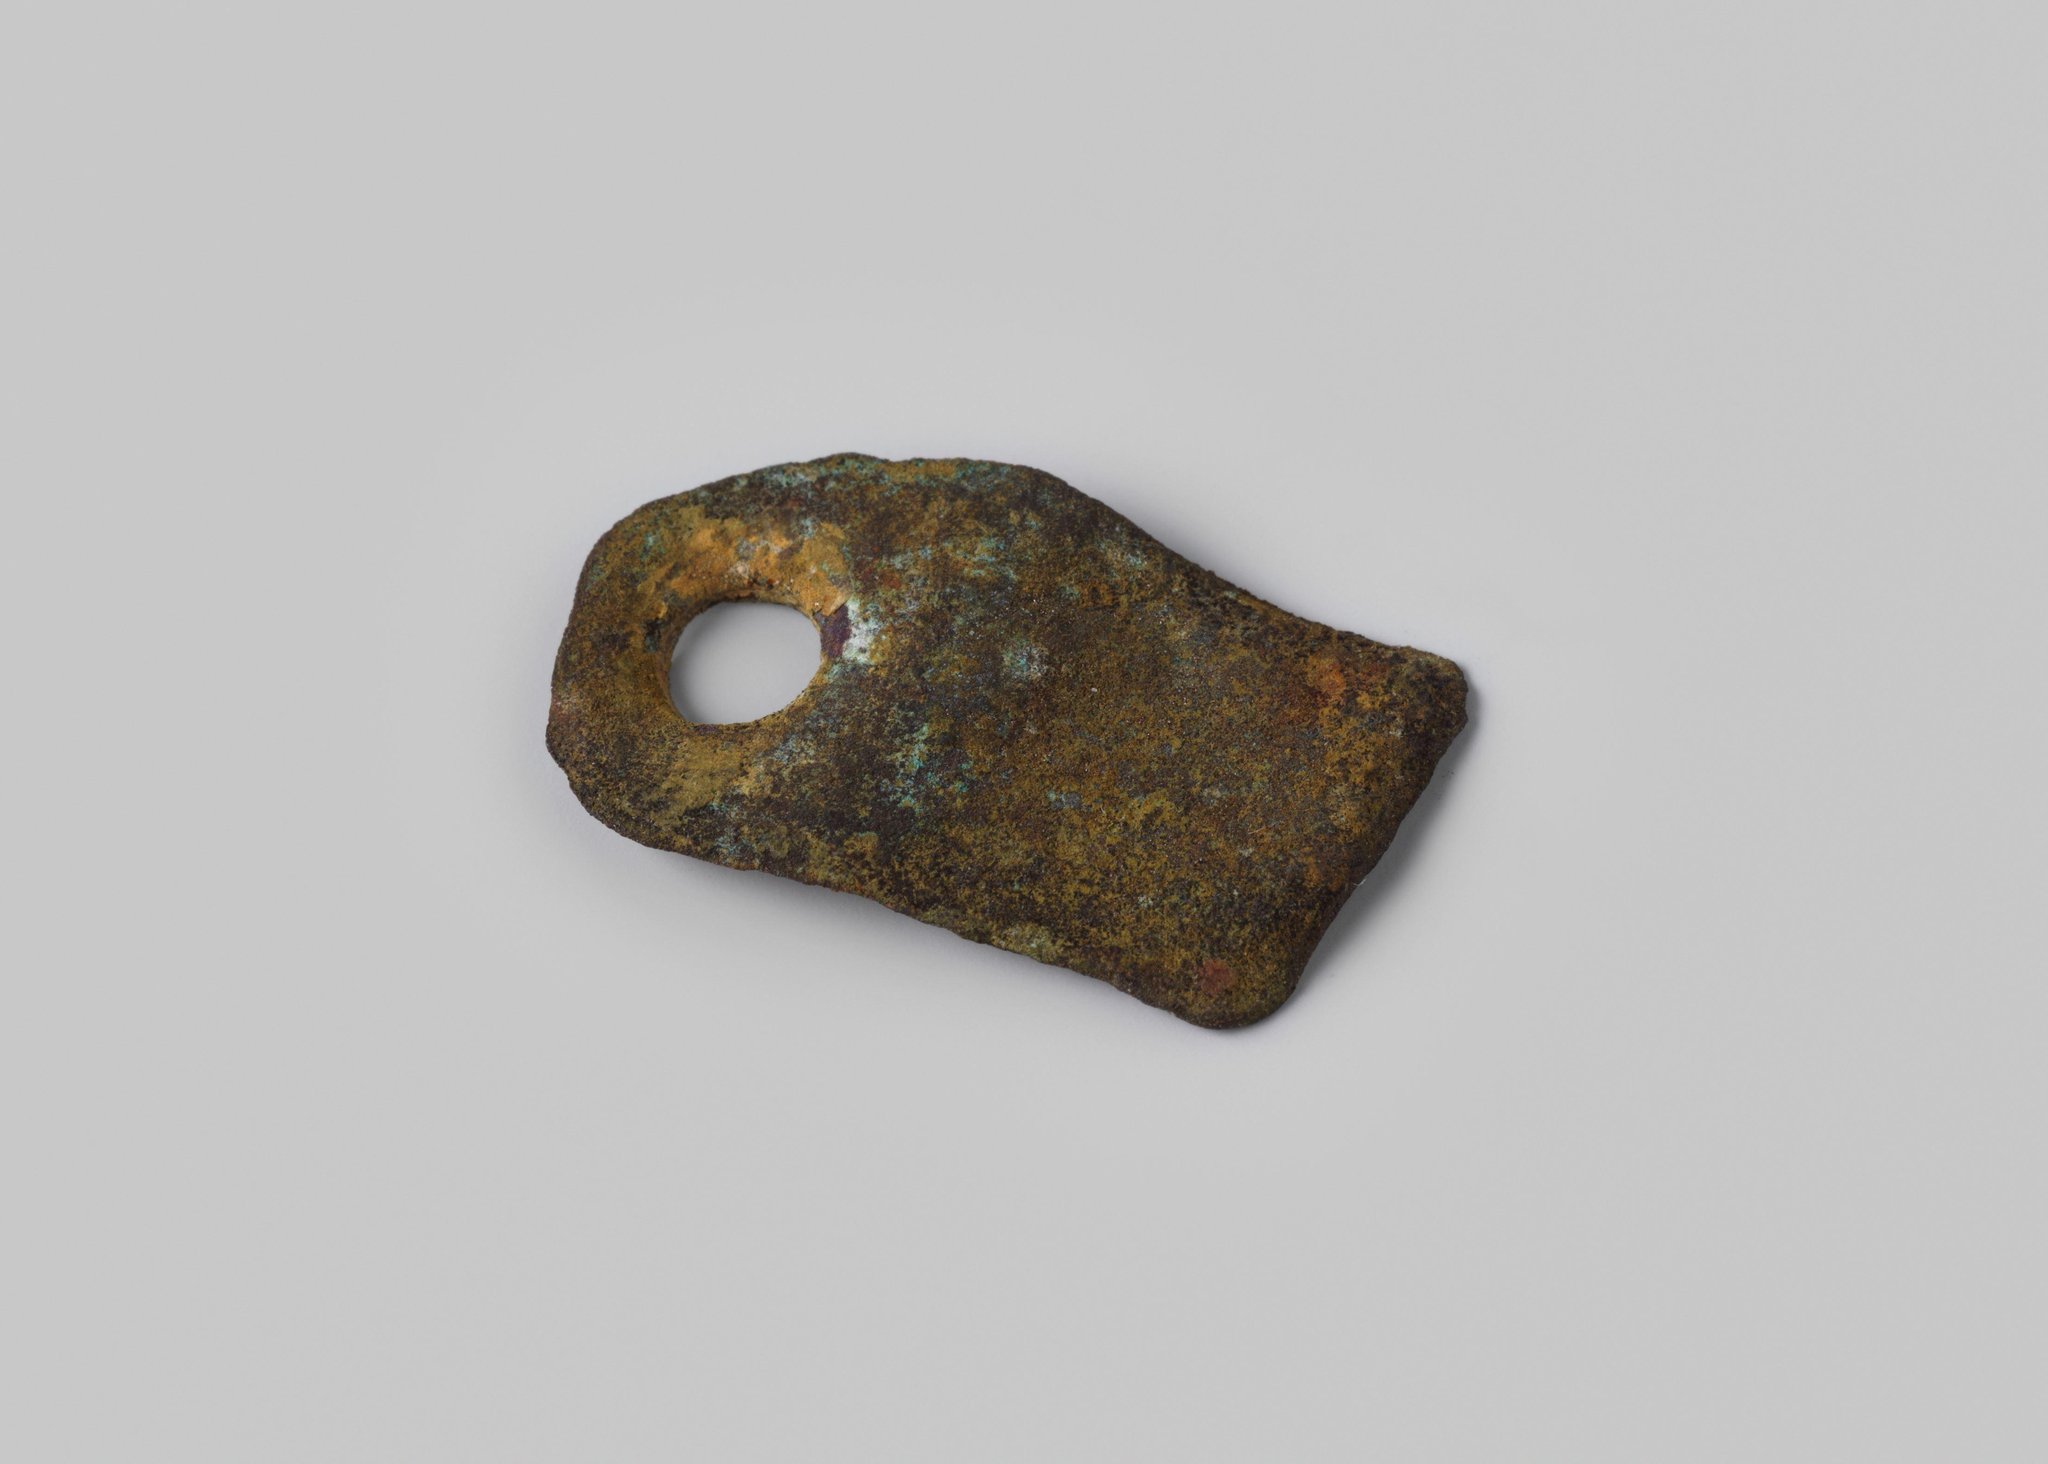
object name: beslag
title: Fragment beslag van koper uit het wrak van de Oost-Indiëvaarder Hollandia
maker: Anonymous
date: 1700-1743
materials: copper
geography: netherlands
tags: verenigde oostindische compagnie, hollandia (schip), annet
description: Varied parts or fragments, strips and strip-shaped fragments; fragm.